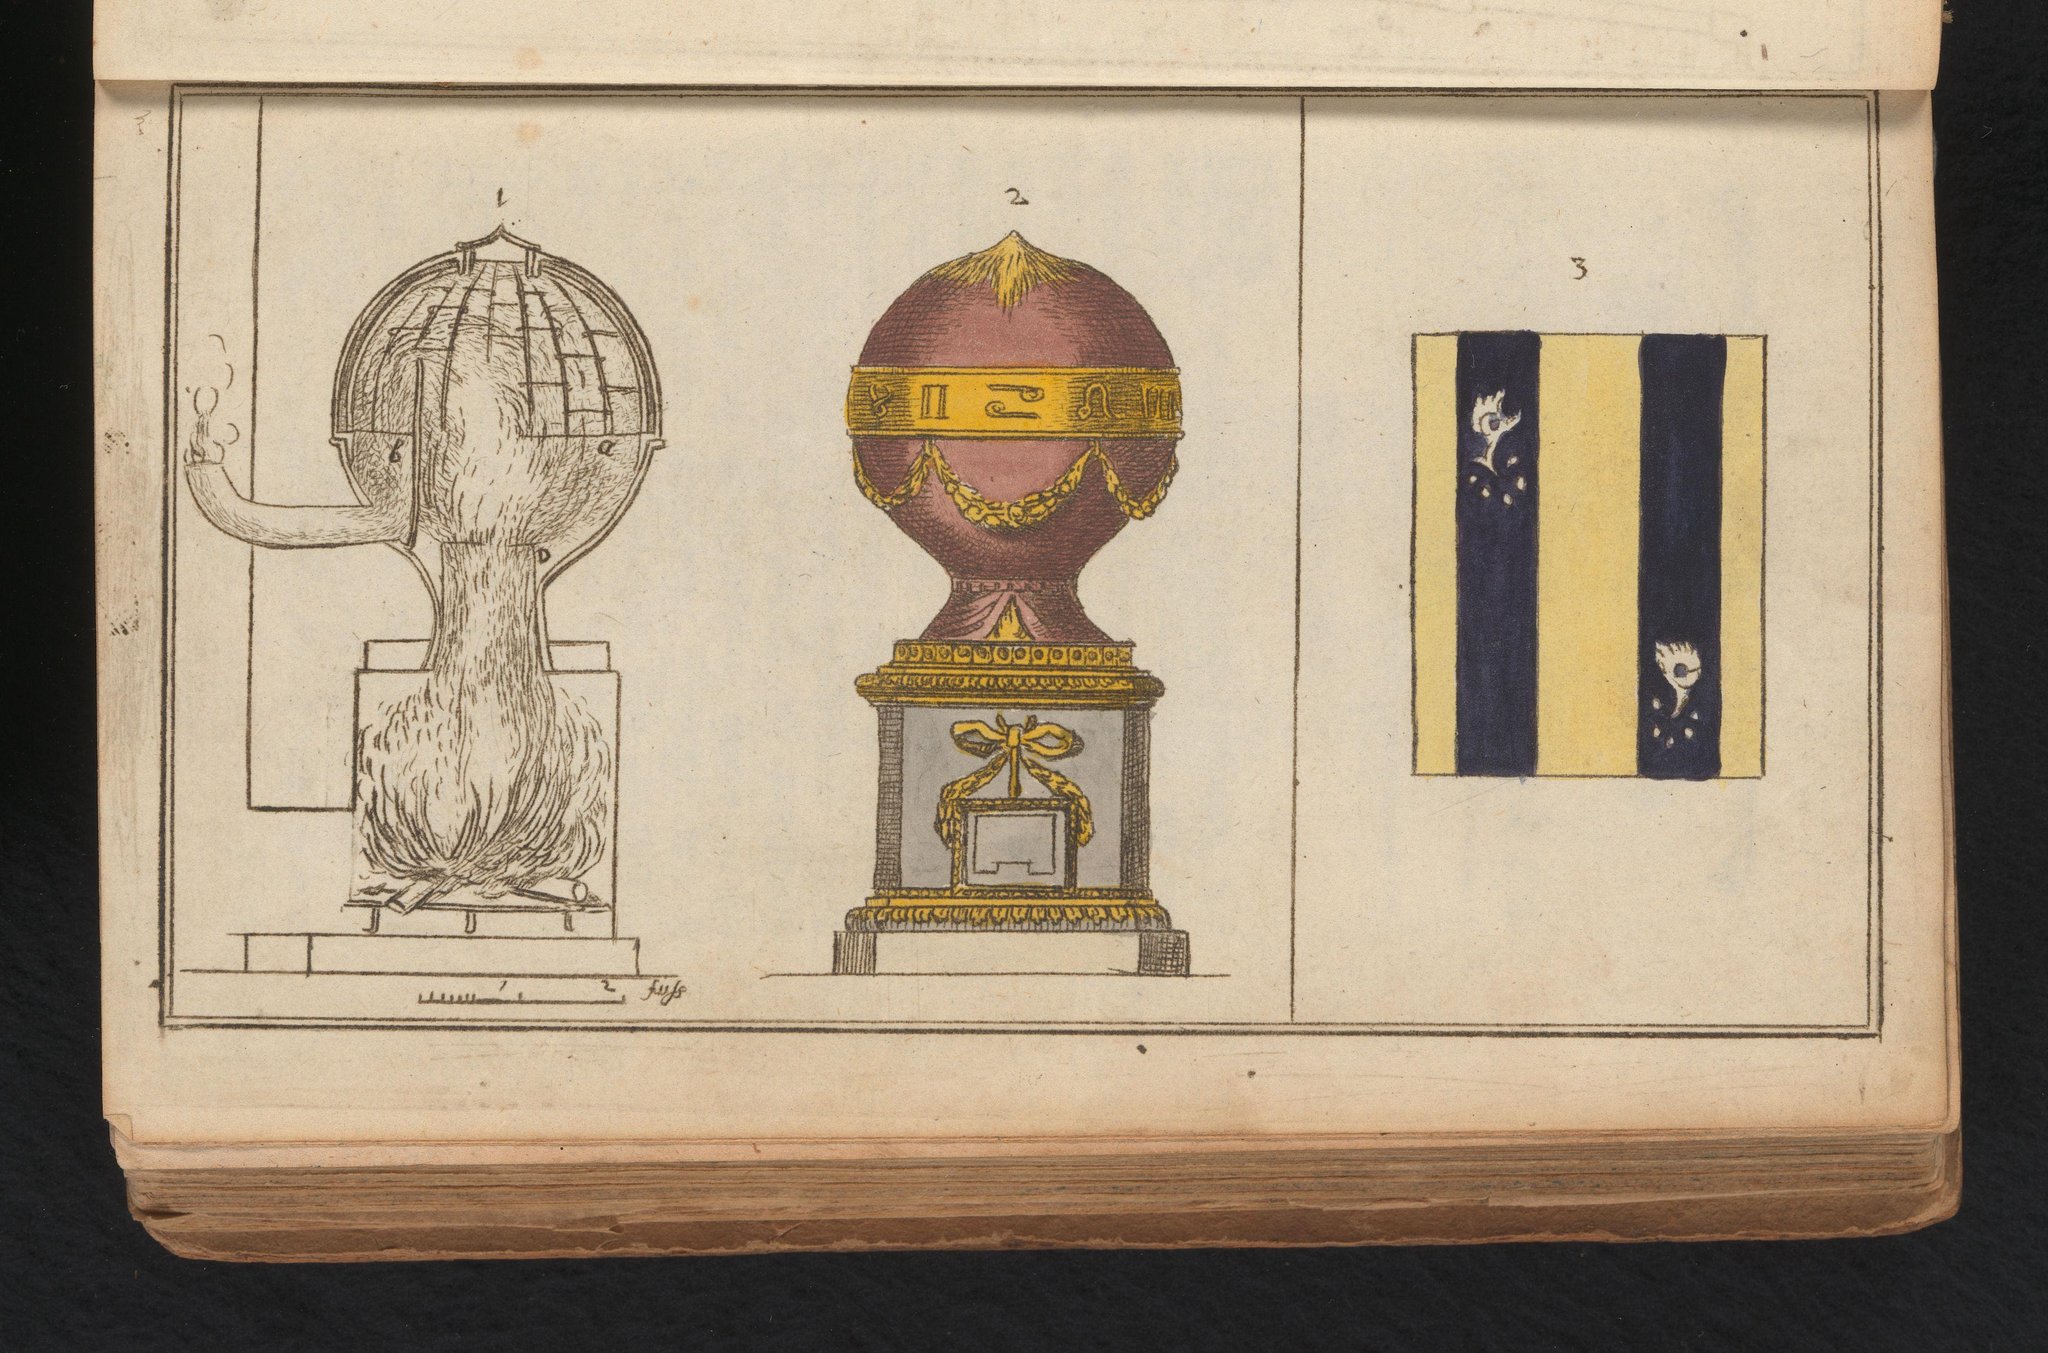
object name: magazine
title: Journal der Moden 1786. T. IV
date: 1786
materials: paper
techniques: etching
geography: gotha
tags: fashion plates